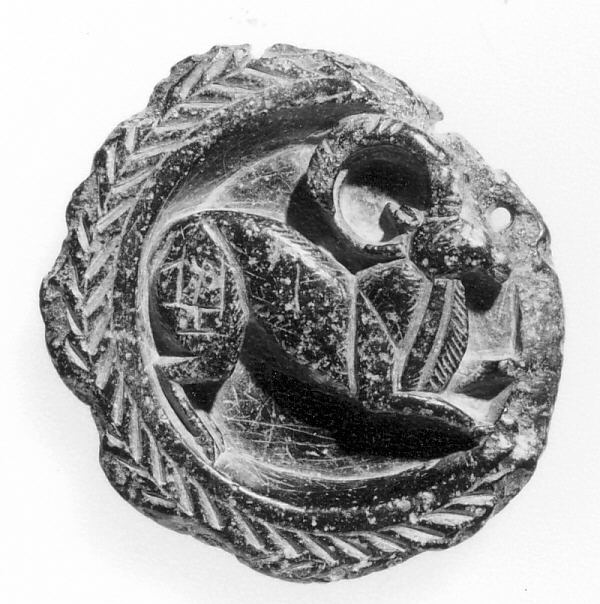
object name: dish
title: Dish with Ram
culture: gandhara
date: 200-1 BCE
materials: stone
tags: gandhara,rams